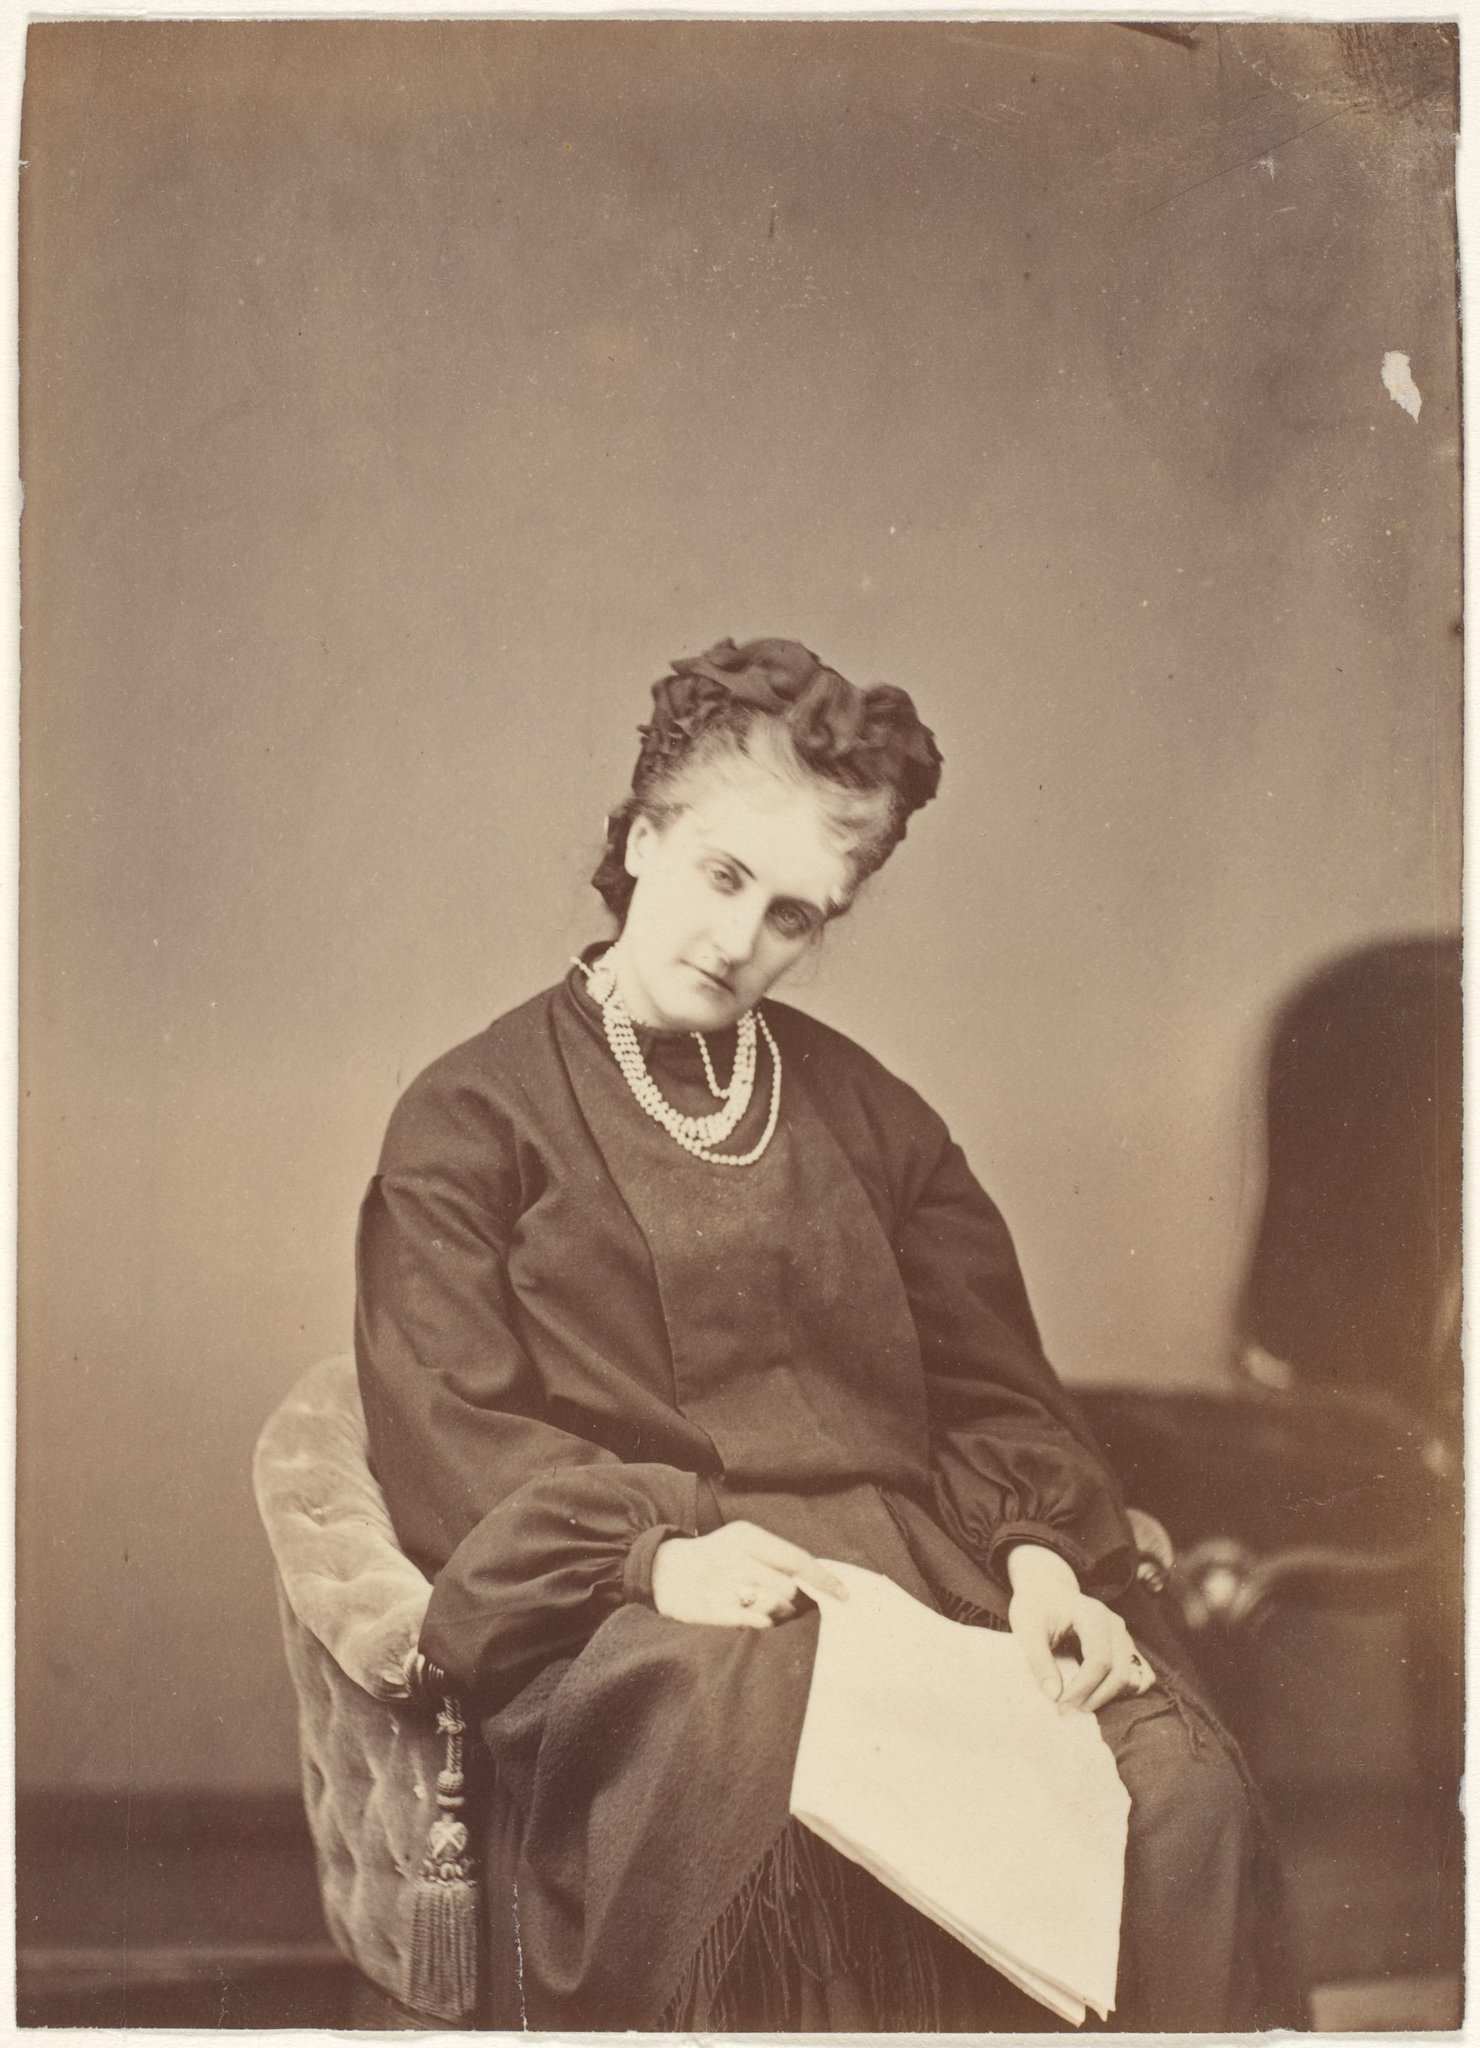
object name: photograph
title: Sèriè à la Ristori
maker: pierre-louis pierson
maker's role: artist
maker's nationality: french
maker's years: 1822-1913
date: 1860-1869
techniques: albumen silver print, glass negative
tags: portraits,women